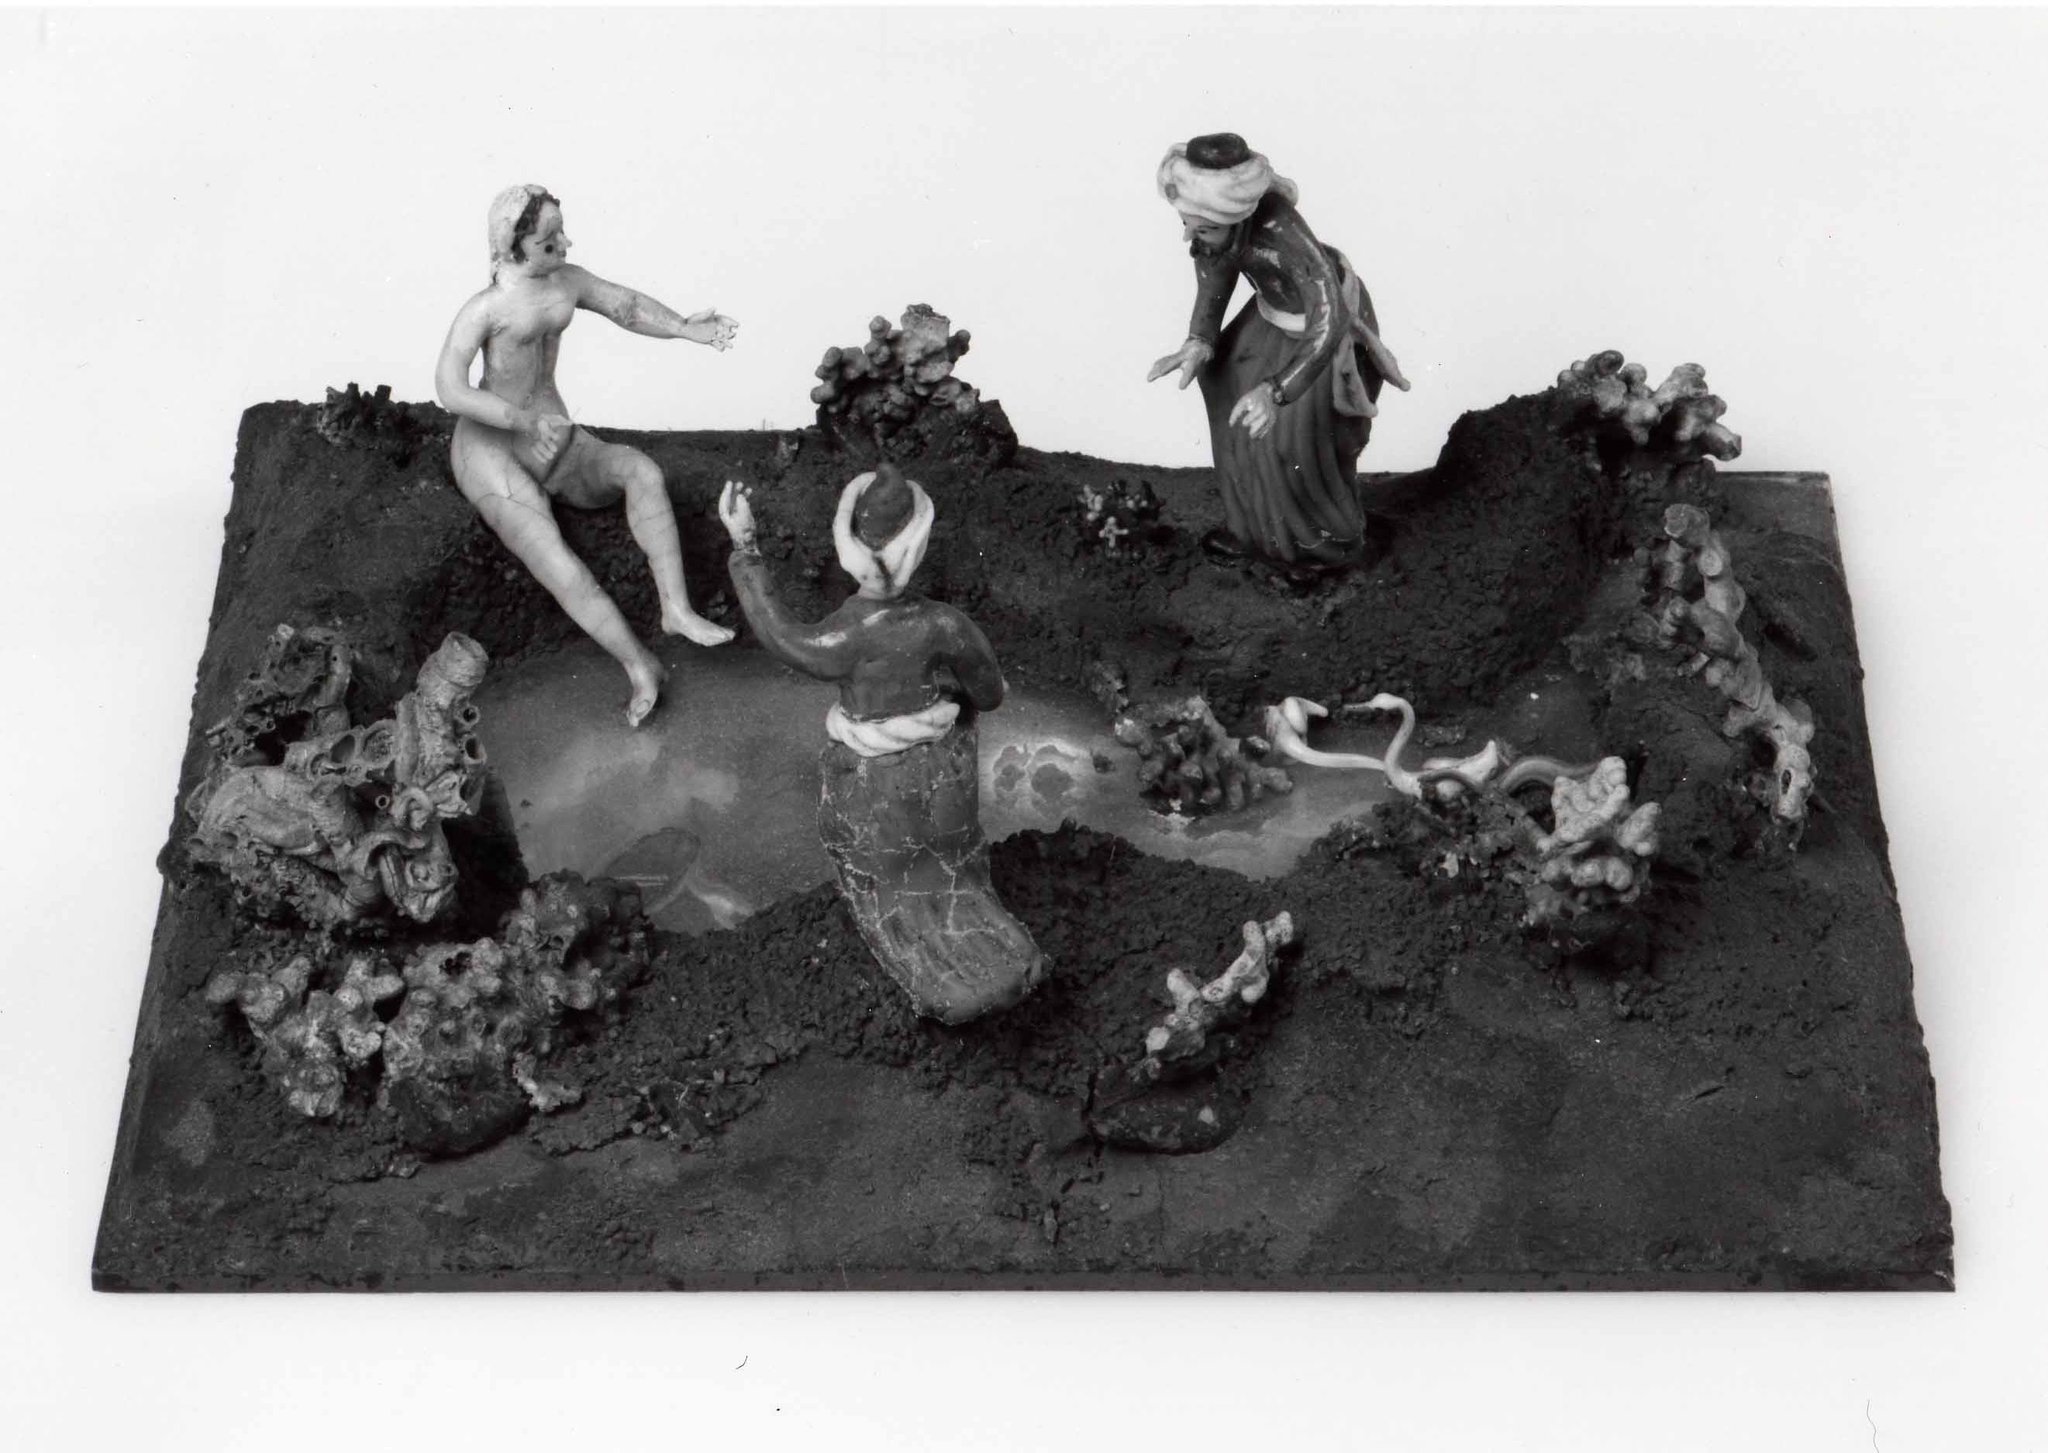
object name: figurine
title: Susanna and the Elders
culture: french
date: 1701-1800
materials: coral, glass, paint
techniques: lampwork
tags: men,female nudes